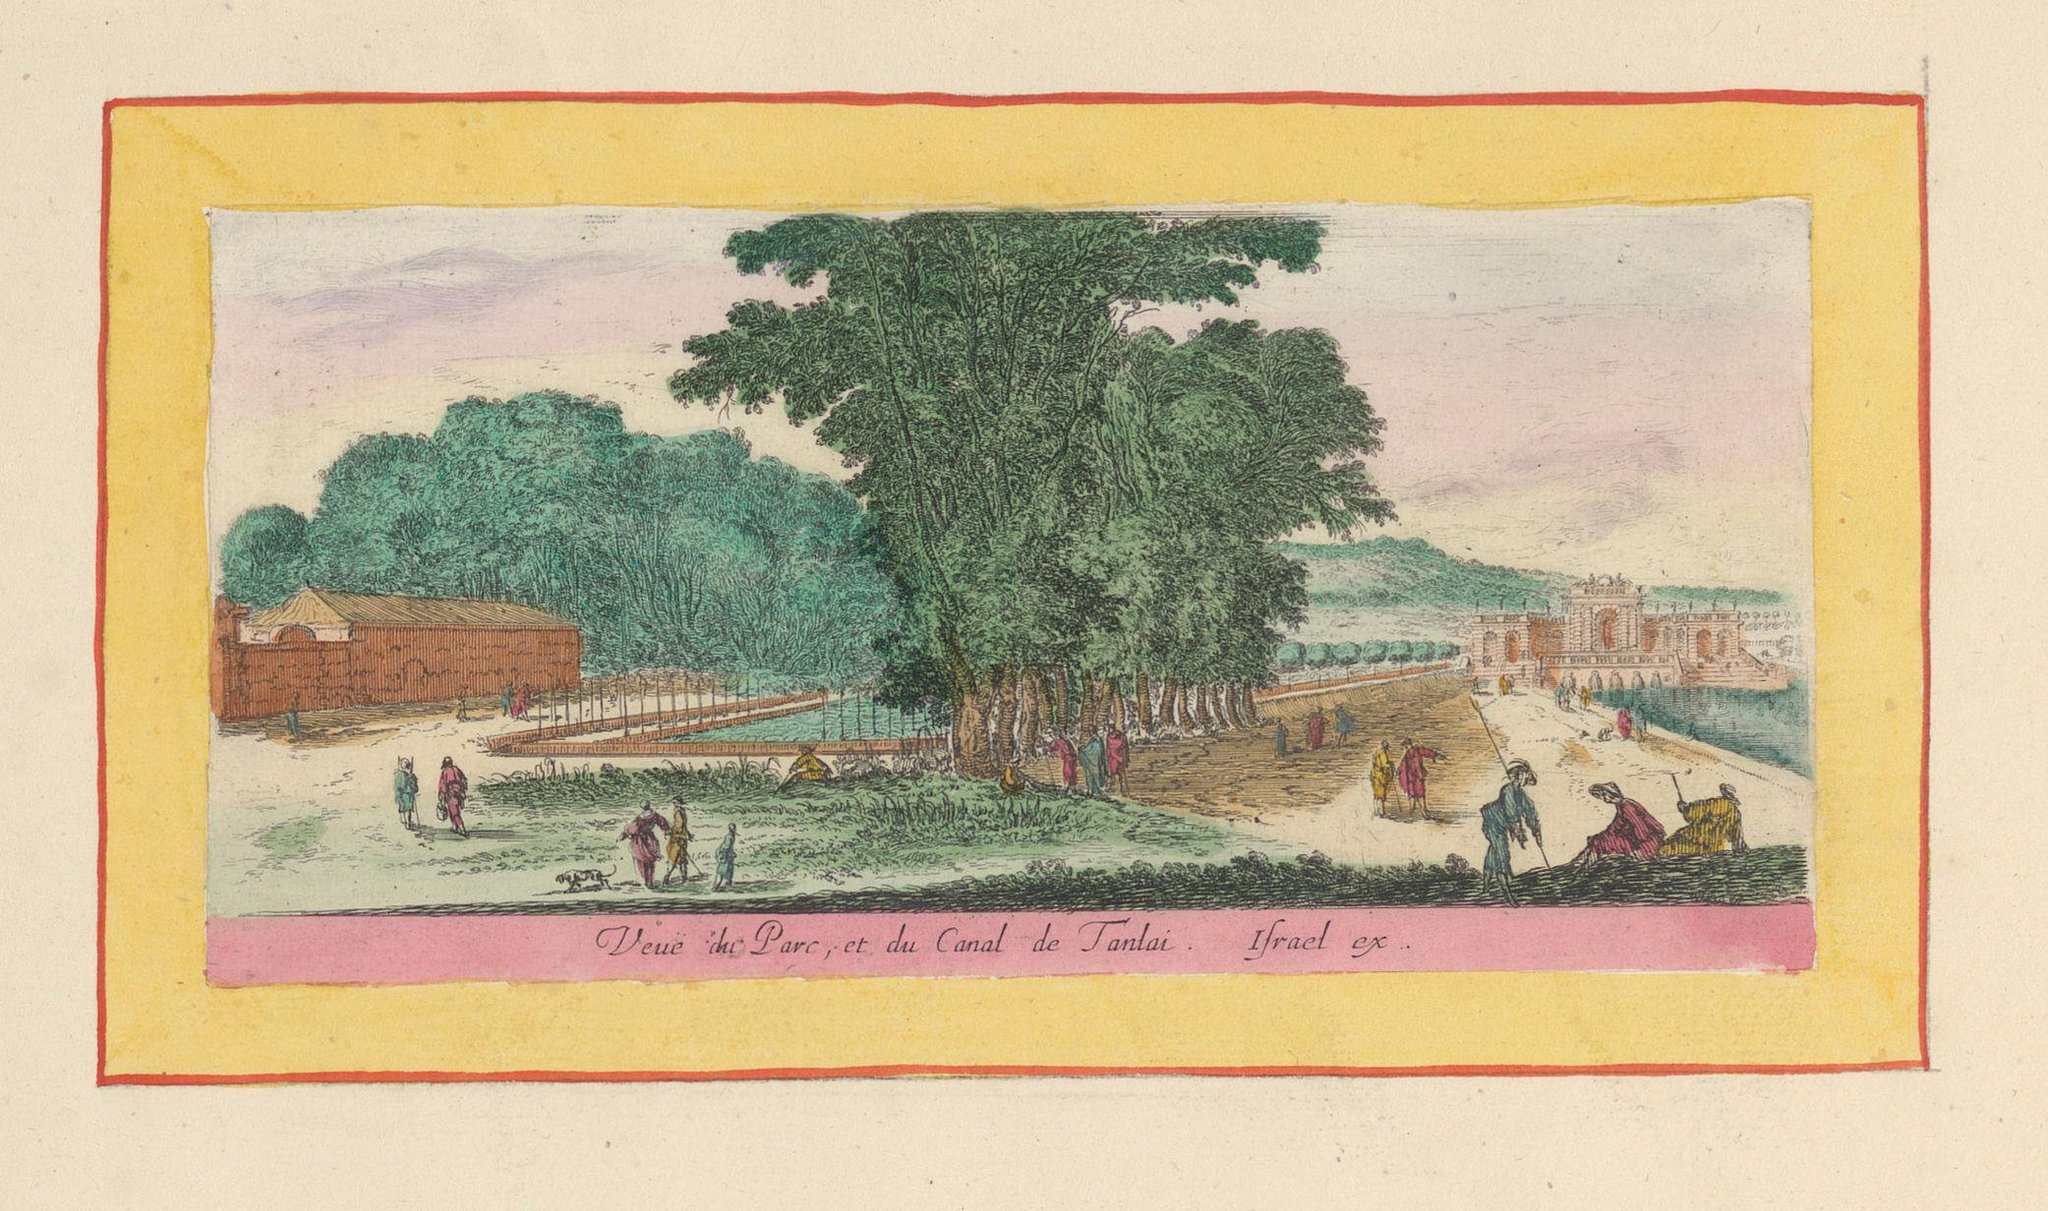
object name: album leaf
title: Omgeving van Tanlay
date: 1631-1661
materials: paper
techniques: etching, hand coloring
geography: paris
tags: castle, landscape with tower or castle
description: Deze prent maakt deel uit van een album.